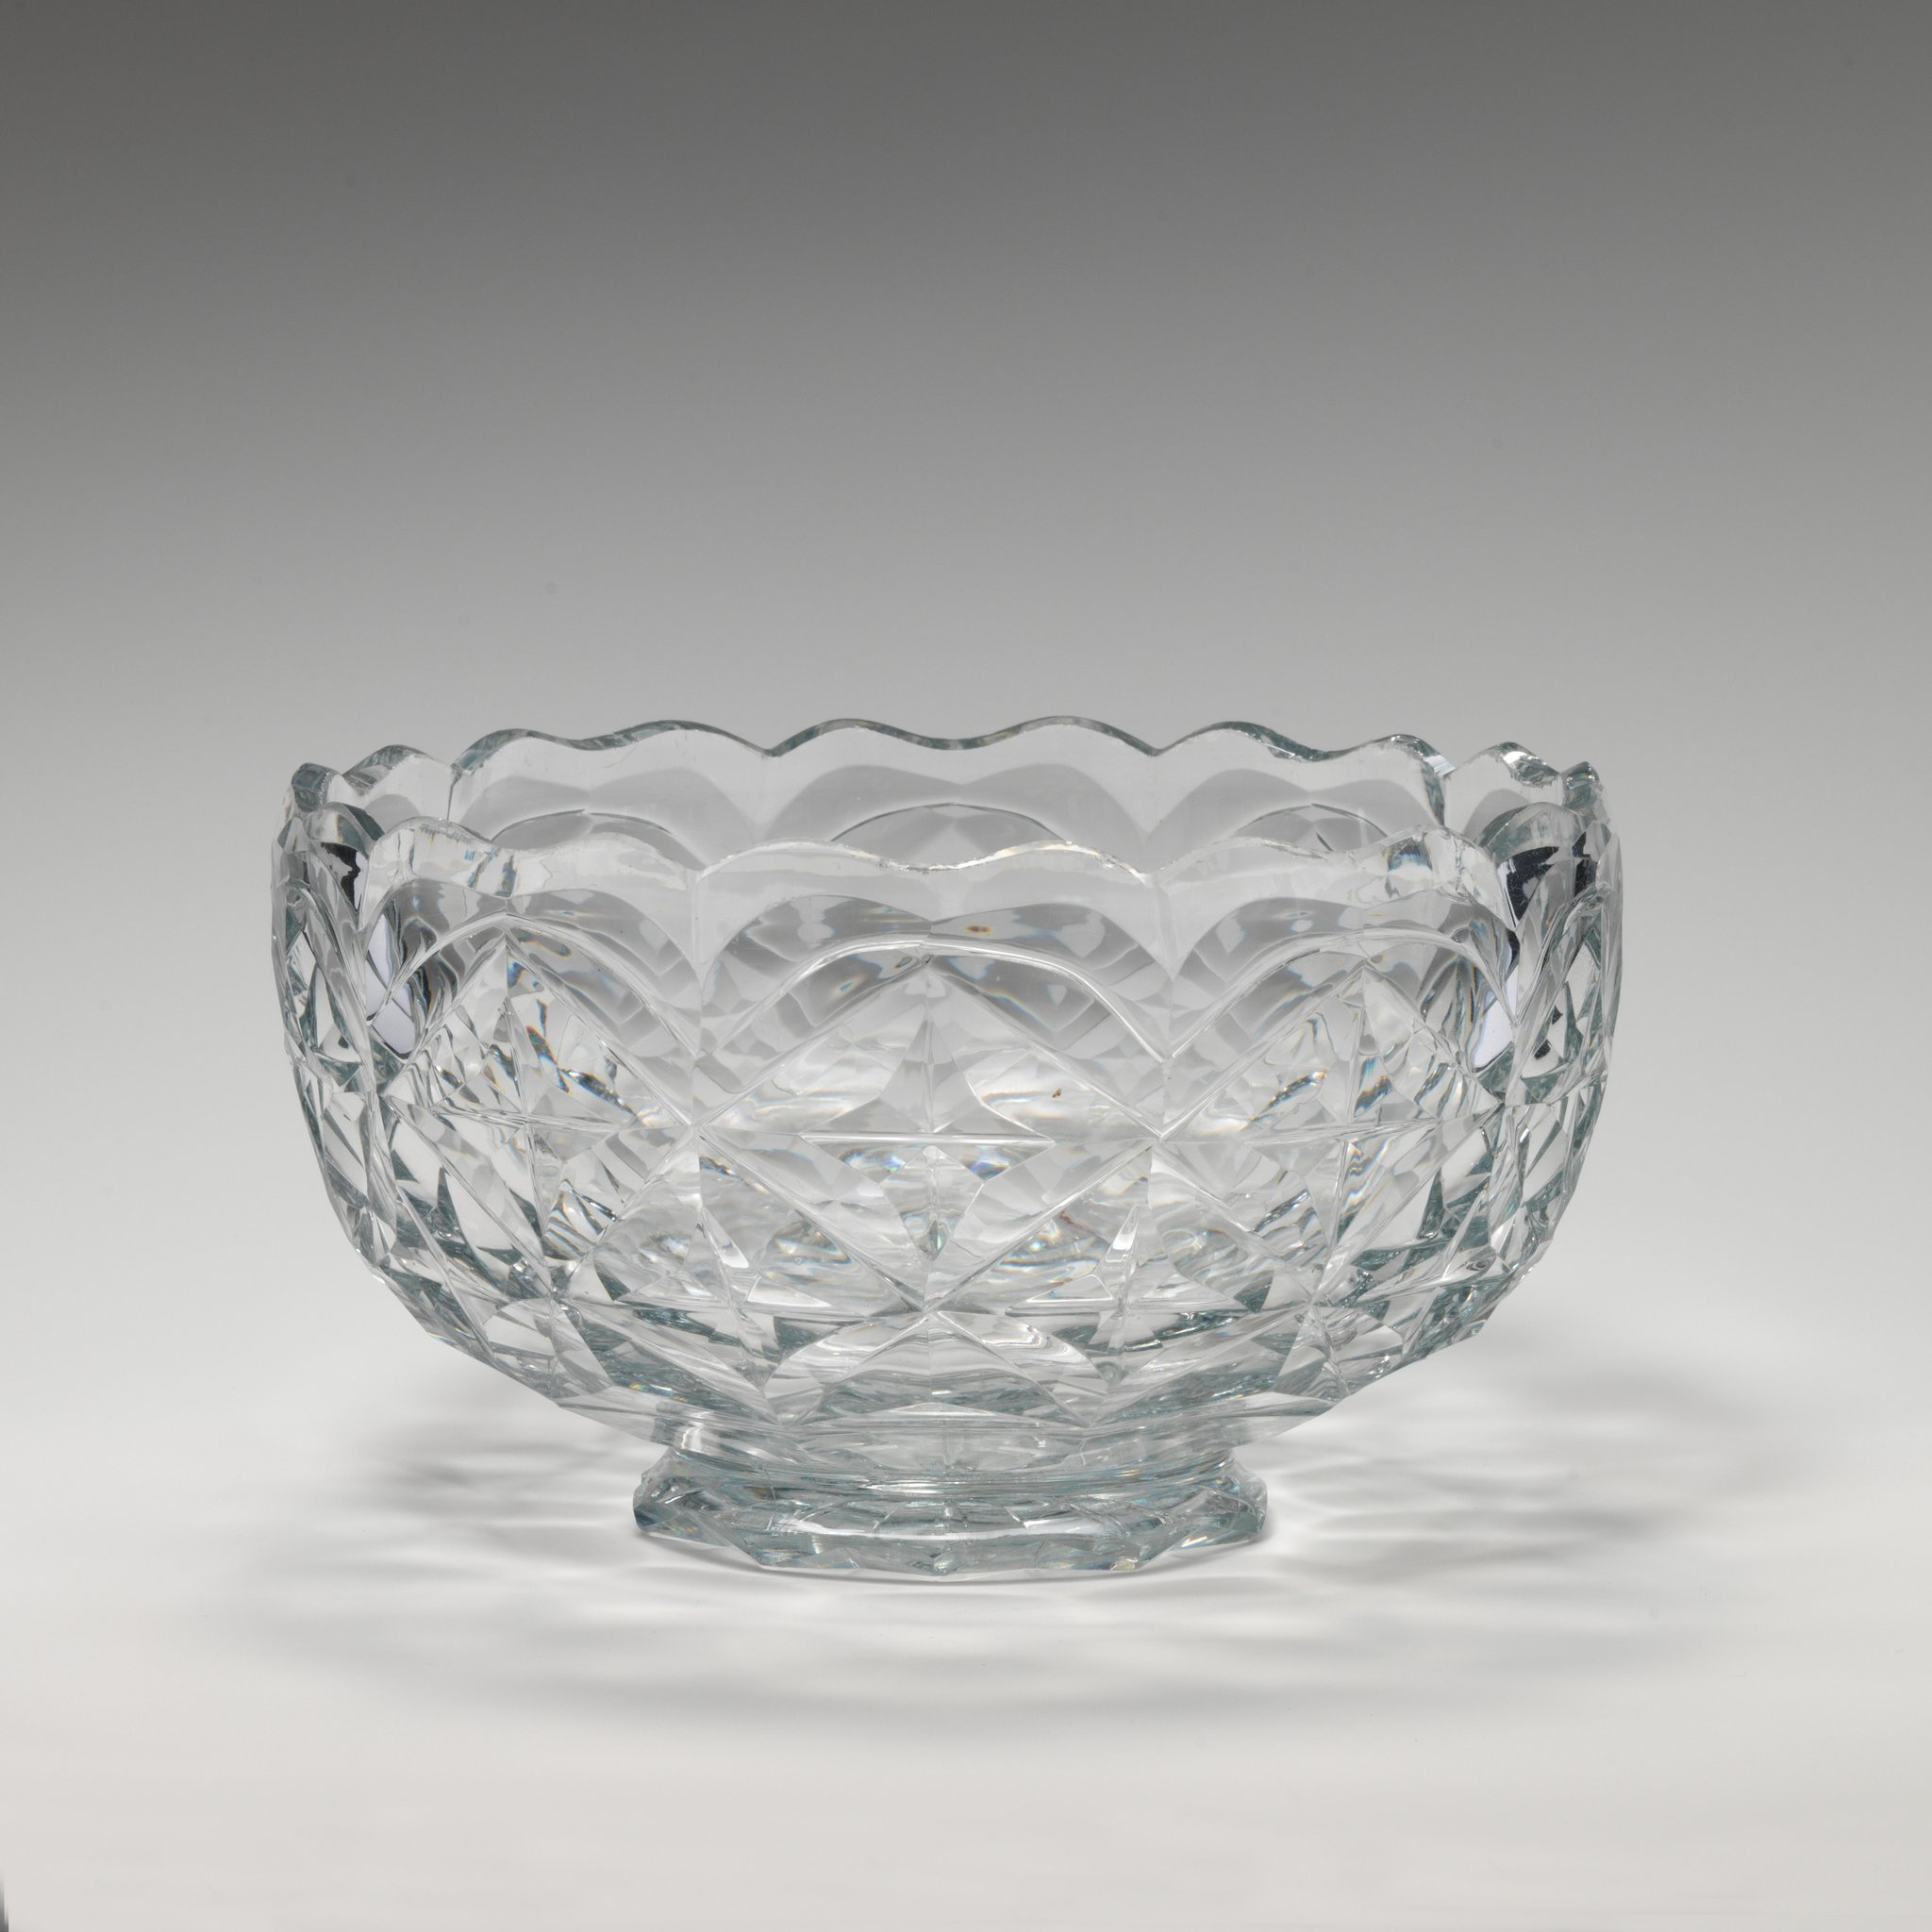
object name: bowl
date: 1775-1800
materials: glass